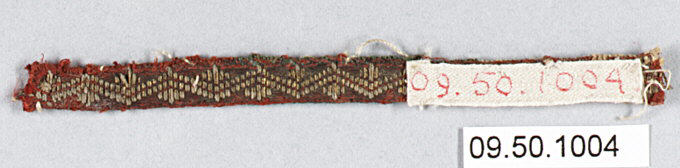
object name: gimp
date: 1701-1900